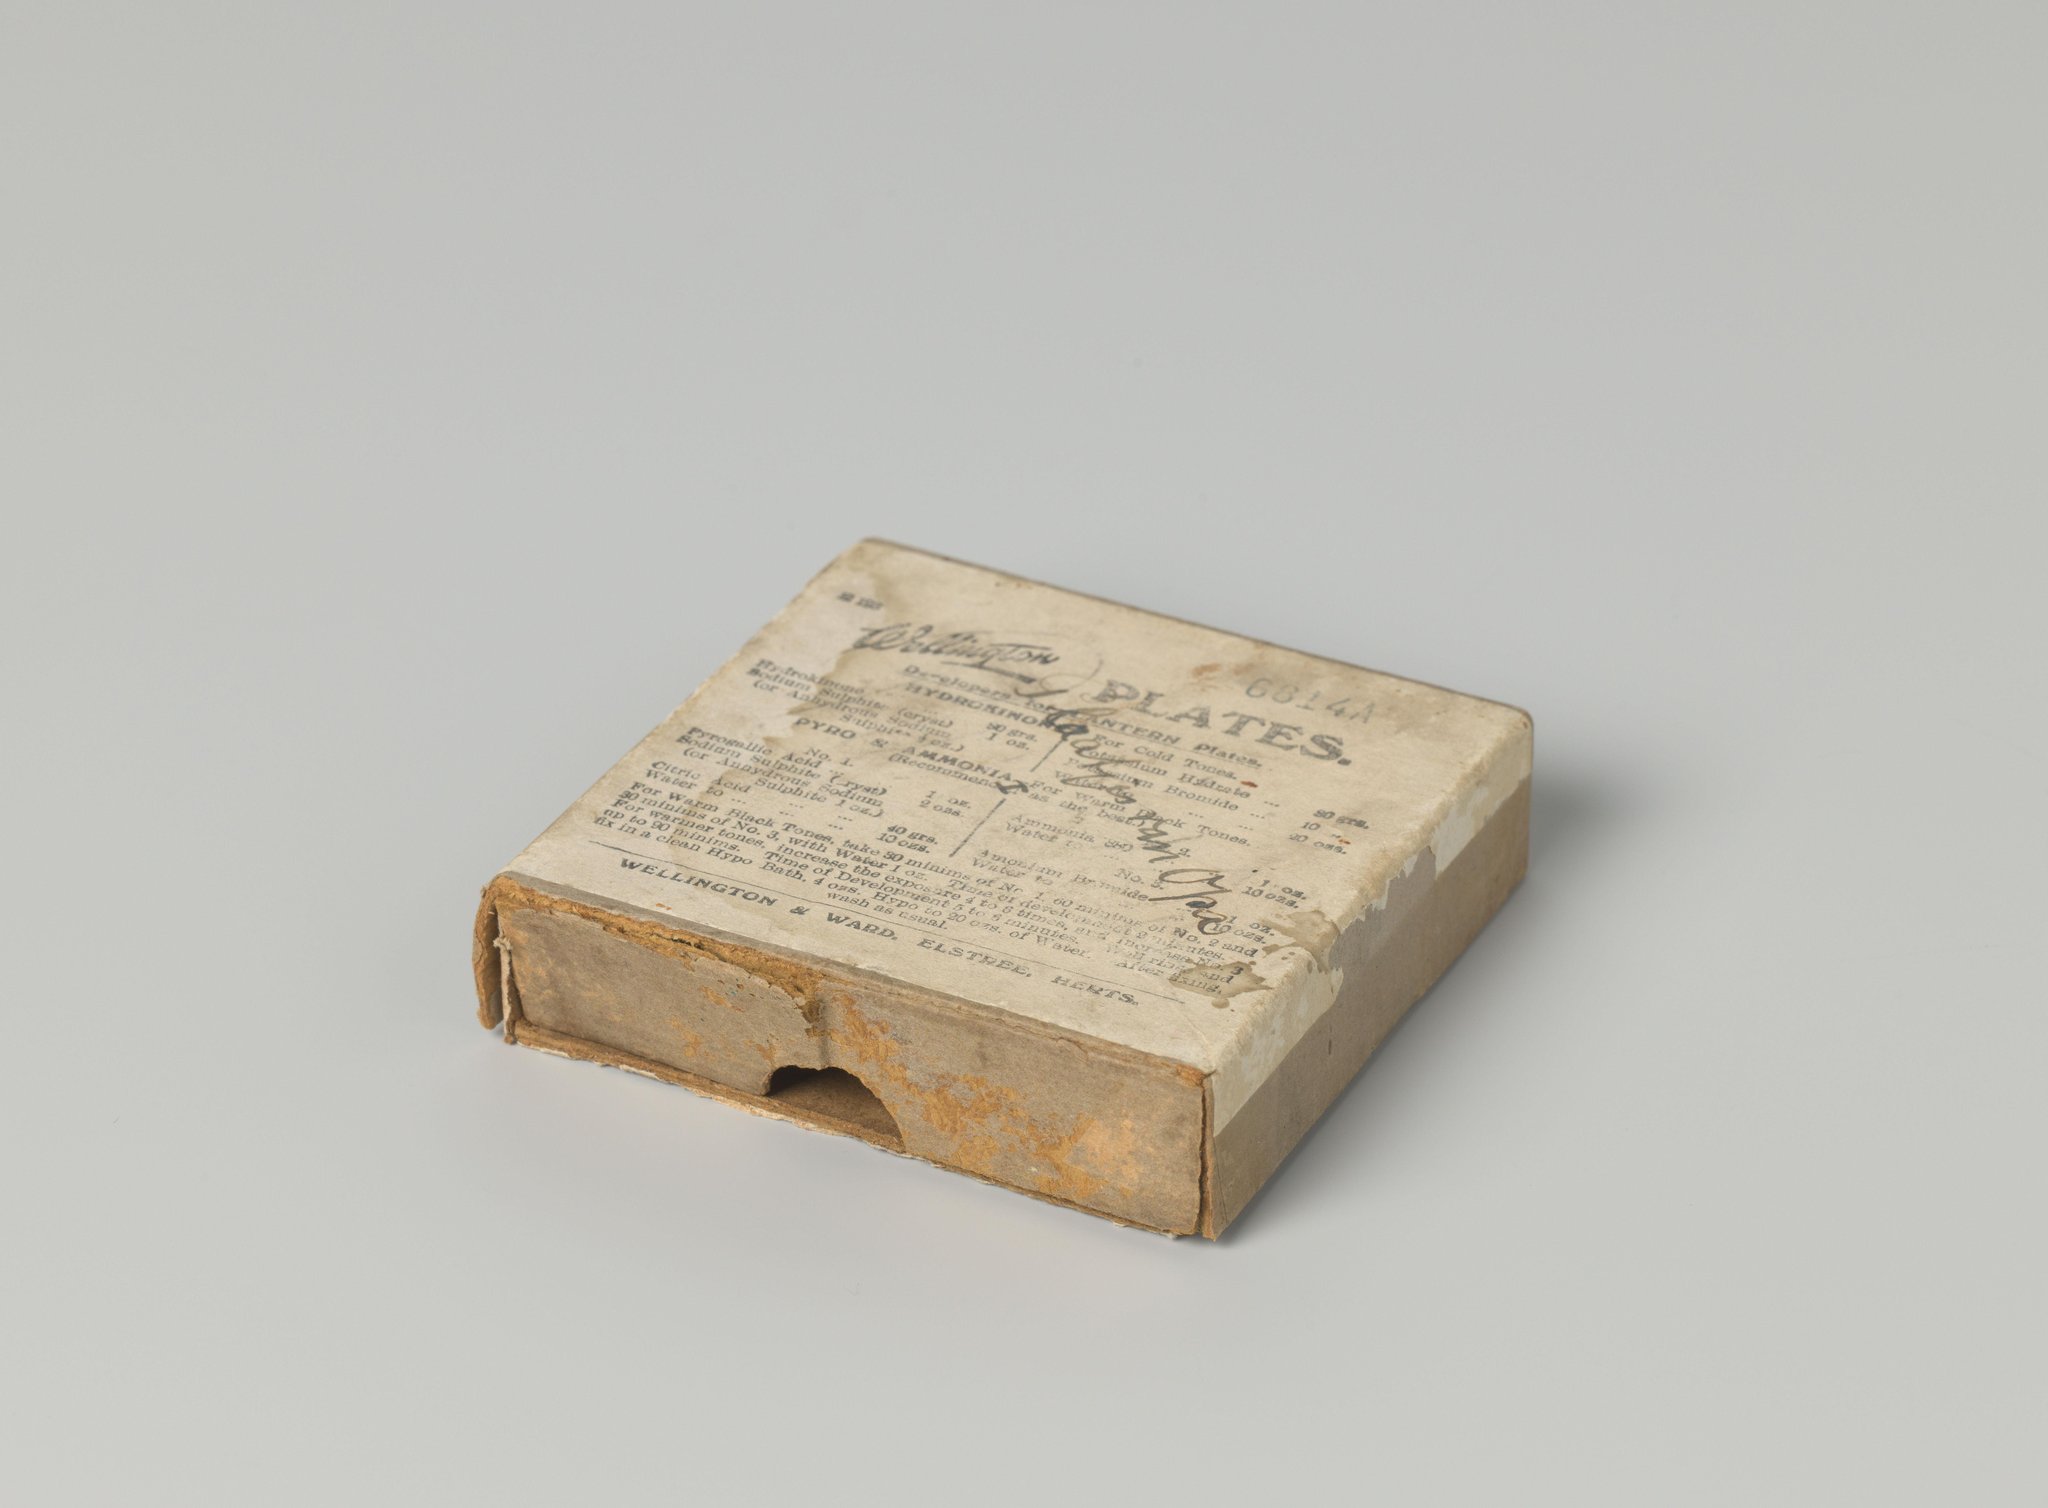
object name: box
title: Doos voor glasplaten van Wellington & Ward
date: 1890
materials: cardboard, paper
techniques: printing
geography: elstree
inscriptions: inscription: ‘Plaatjes van Opa/ I’, number: ‘6814A’